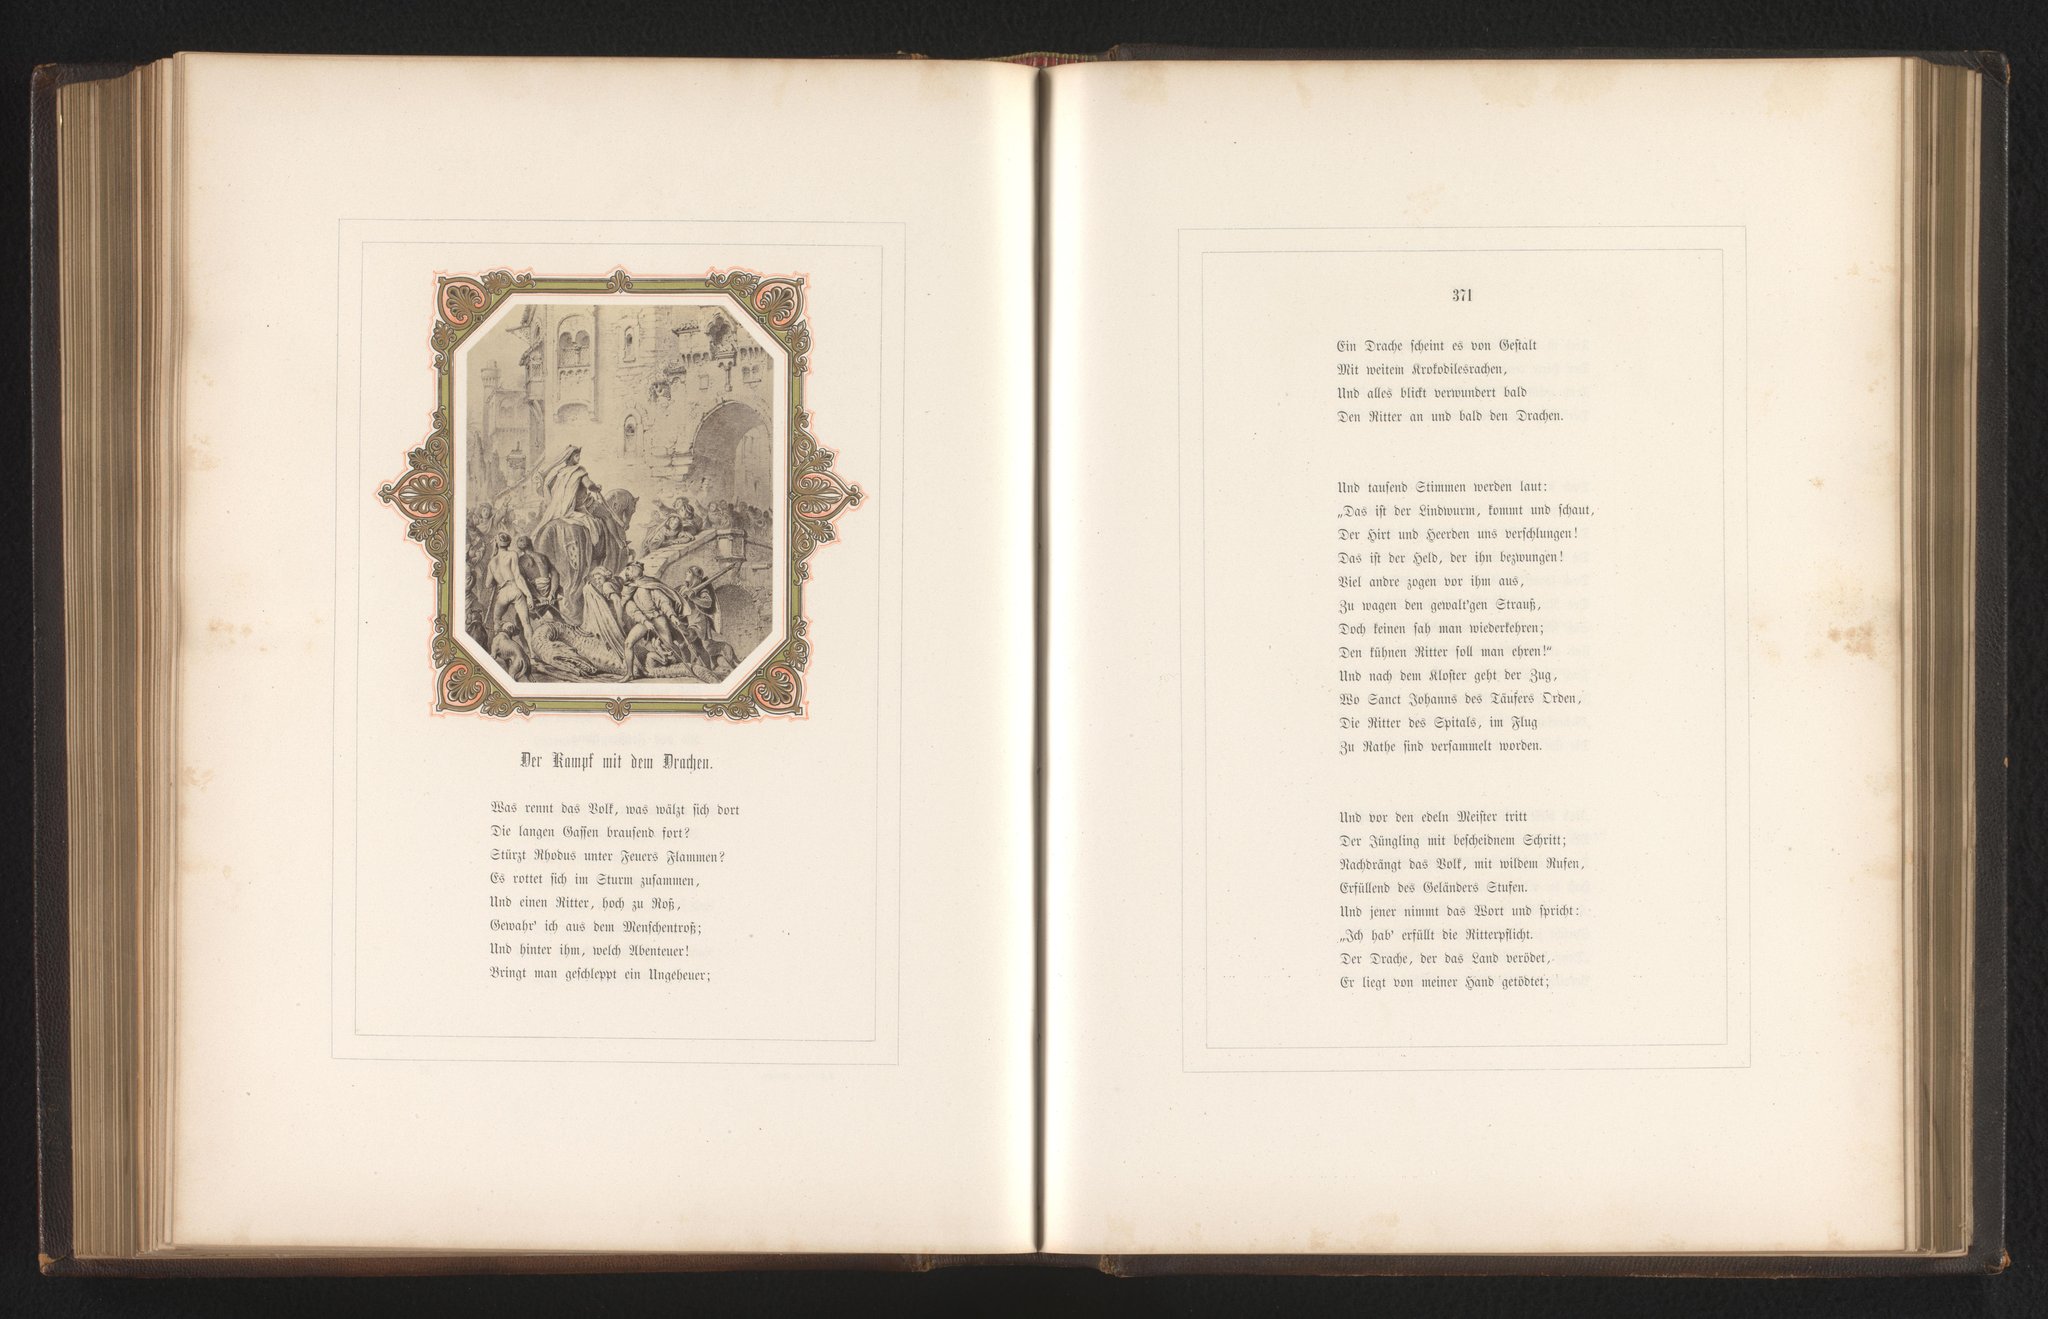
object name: reproduction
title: Ramberg: Der Kampf met dem Drachen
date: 1855-1862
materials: paper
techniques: albumen print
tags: gate ~ fortified city, dragon